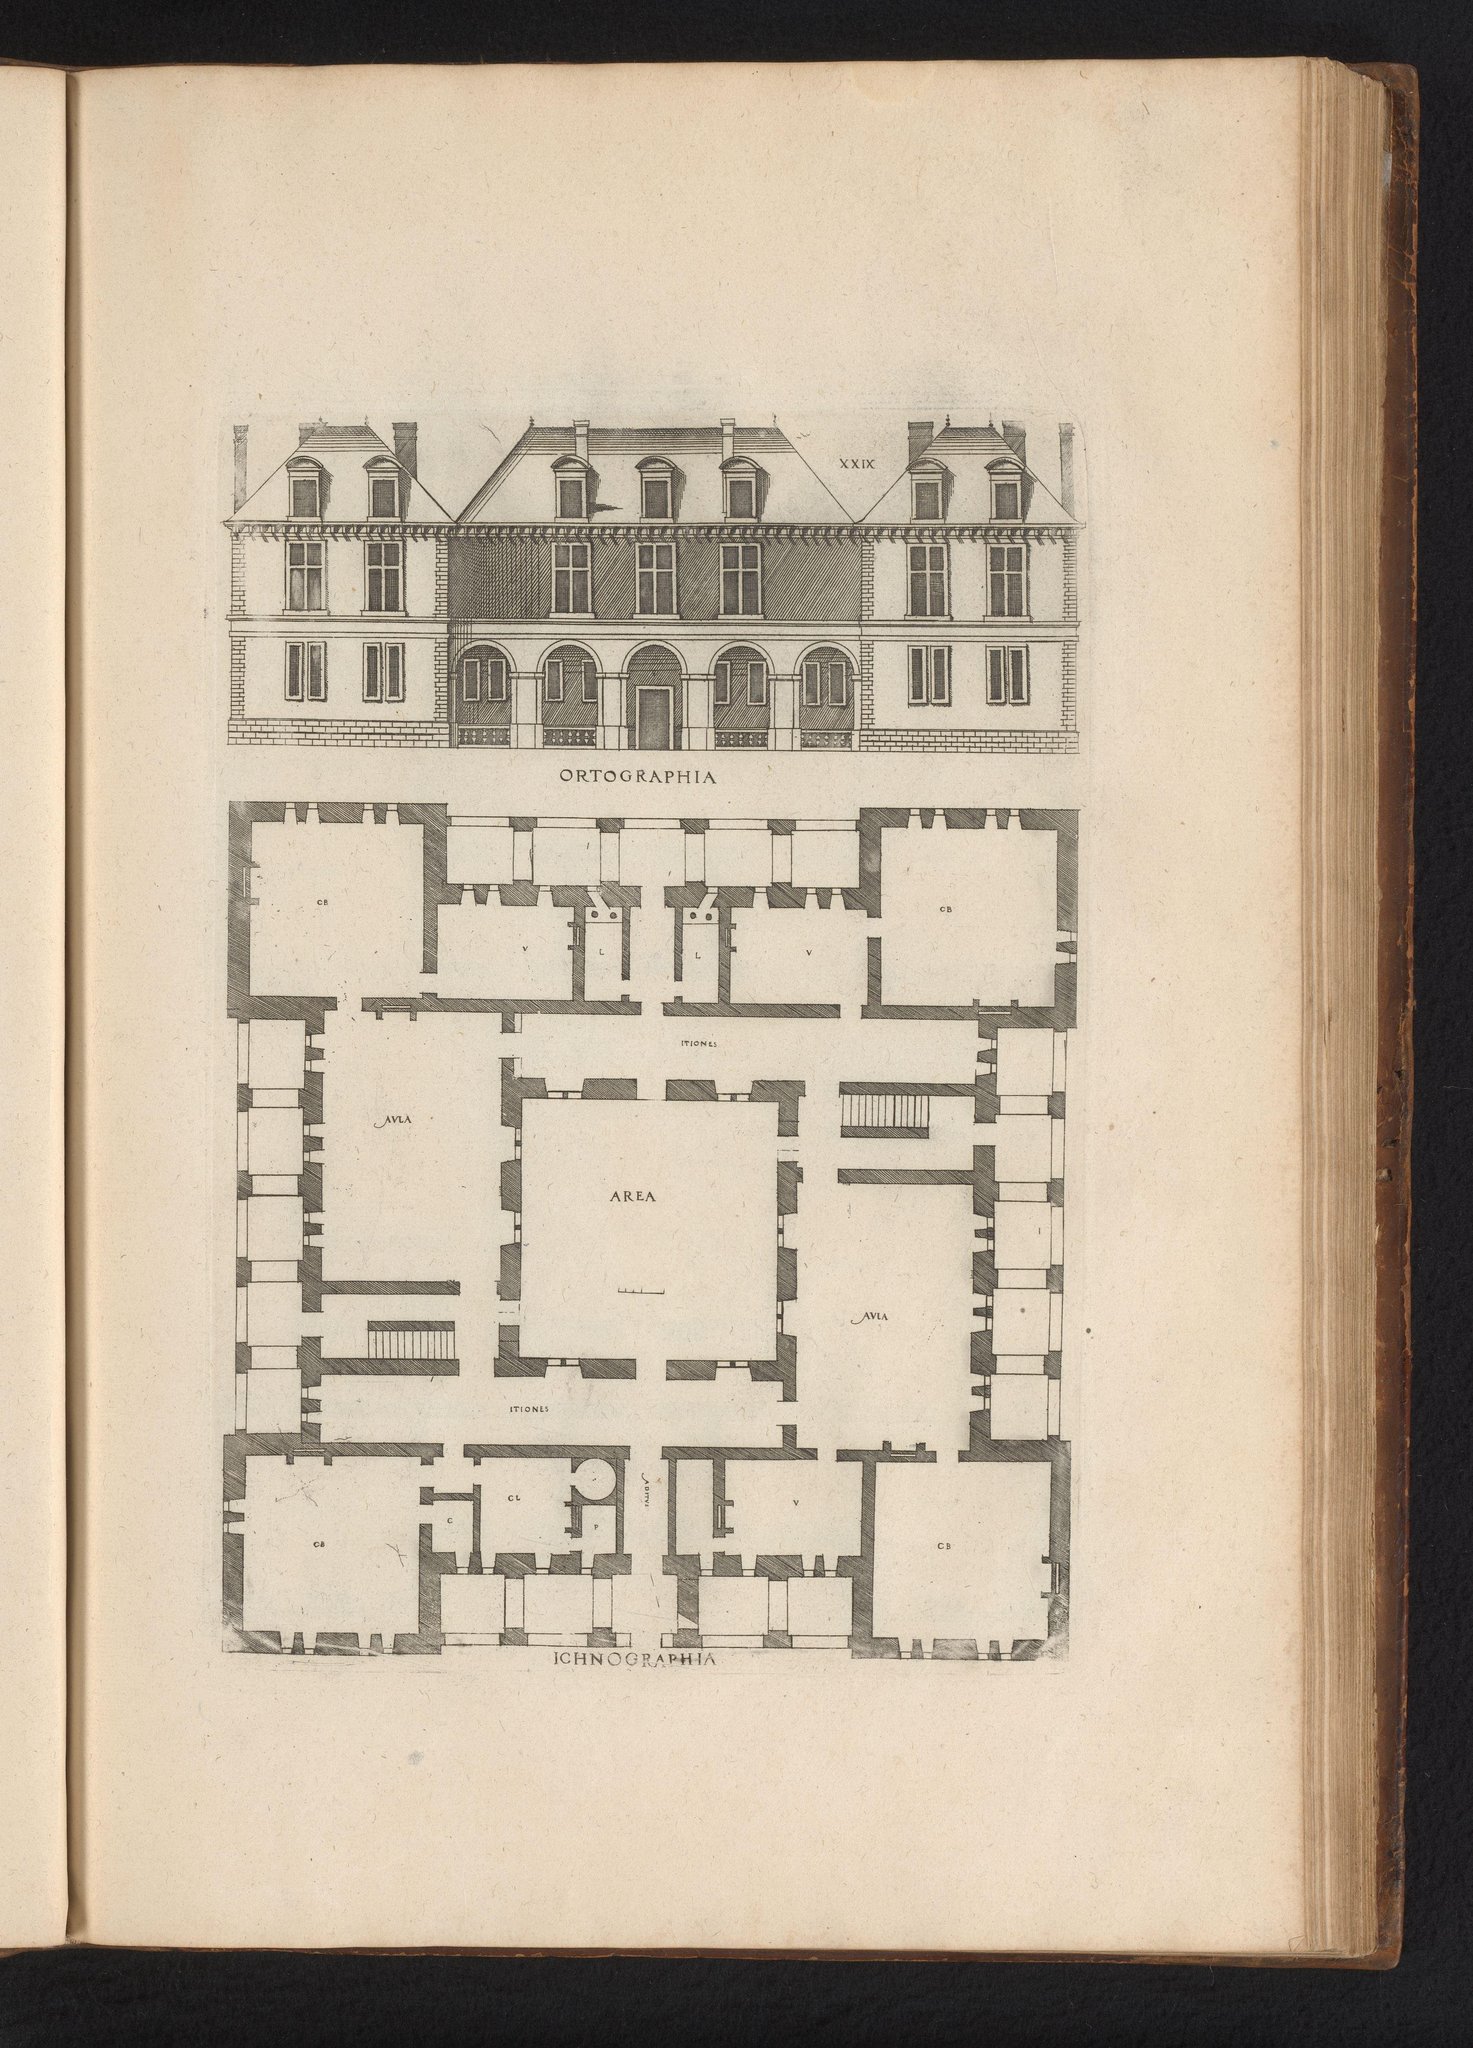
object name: ornament print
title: Voorgevel en plattegrond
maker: jacques androuet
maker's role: draughtsman, print maker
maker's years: 1515-1584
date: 1559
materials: paper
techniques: etching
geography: paris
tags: façade (of house or building), plan ~ architecture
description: Voorgevel en plattegrond. Aanzicht en plattegrond van architectuur. Genummerd: XXIX. Onderdeel van 'De architectura Iacobi Androuetii du Cerceau' (1559): 69 etsen met 171 voorstellingen van architectuur en ornamentiek.